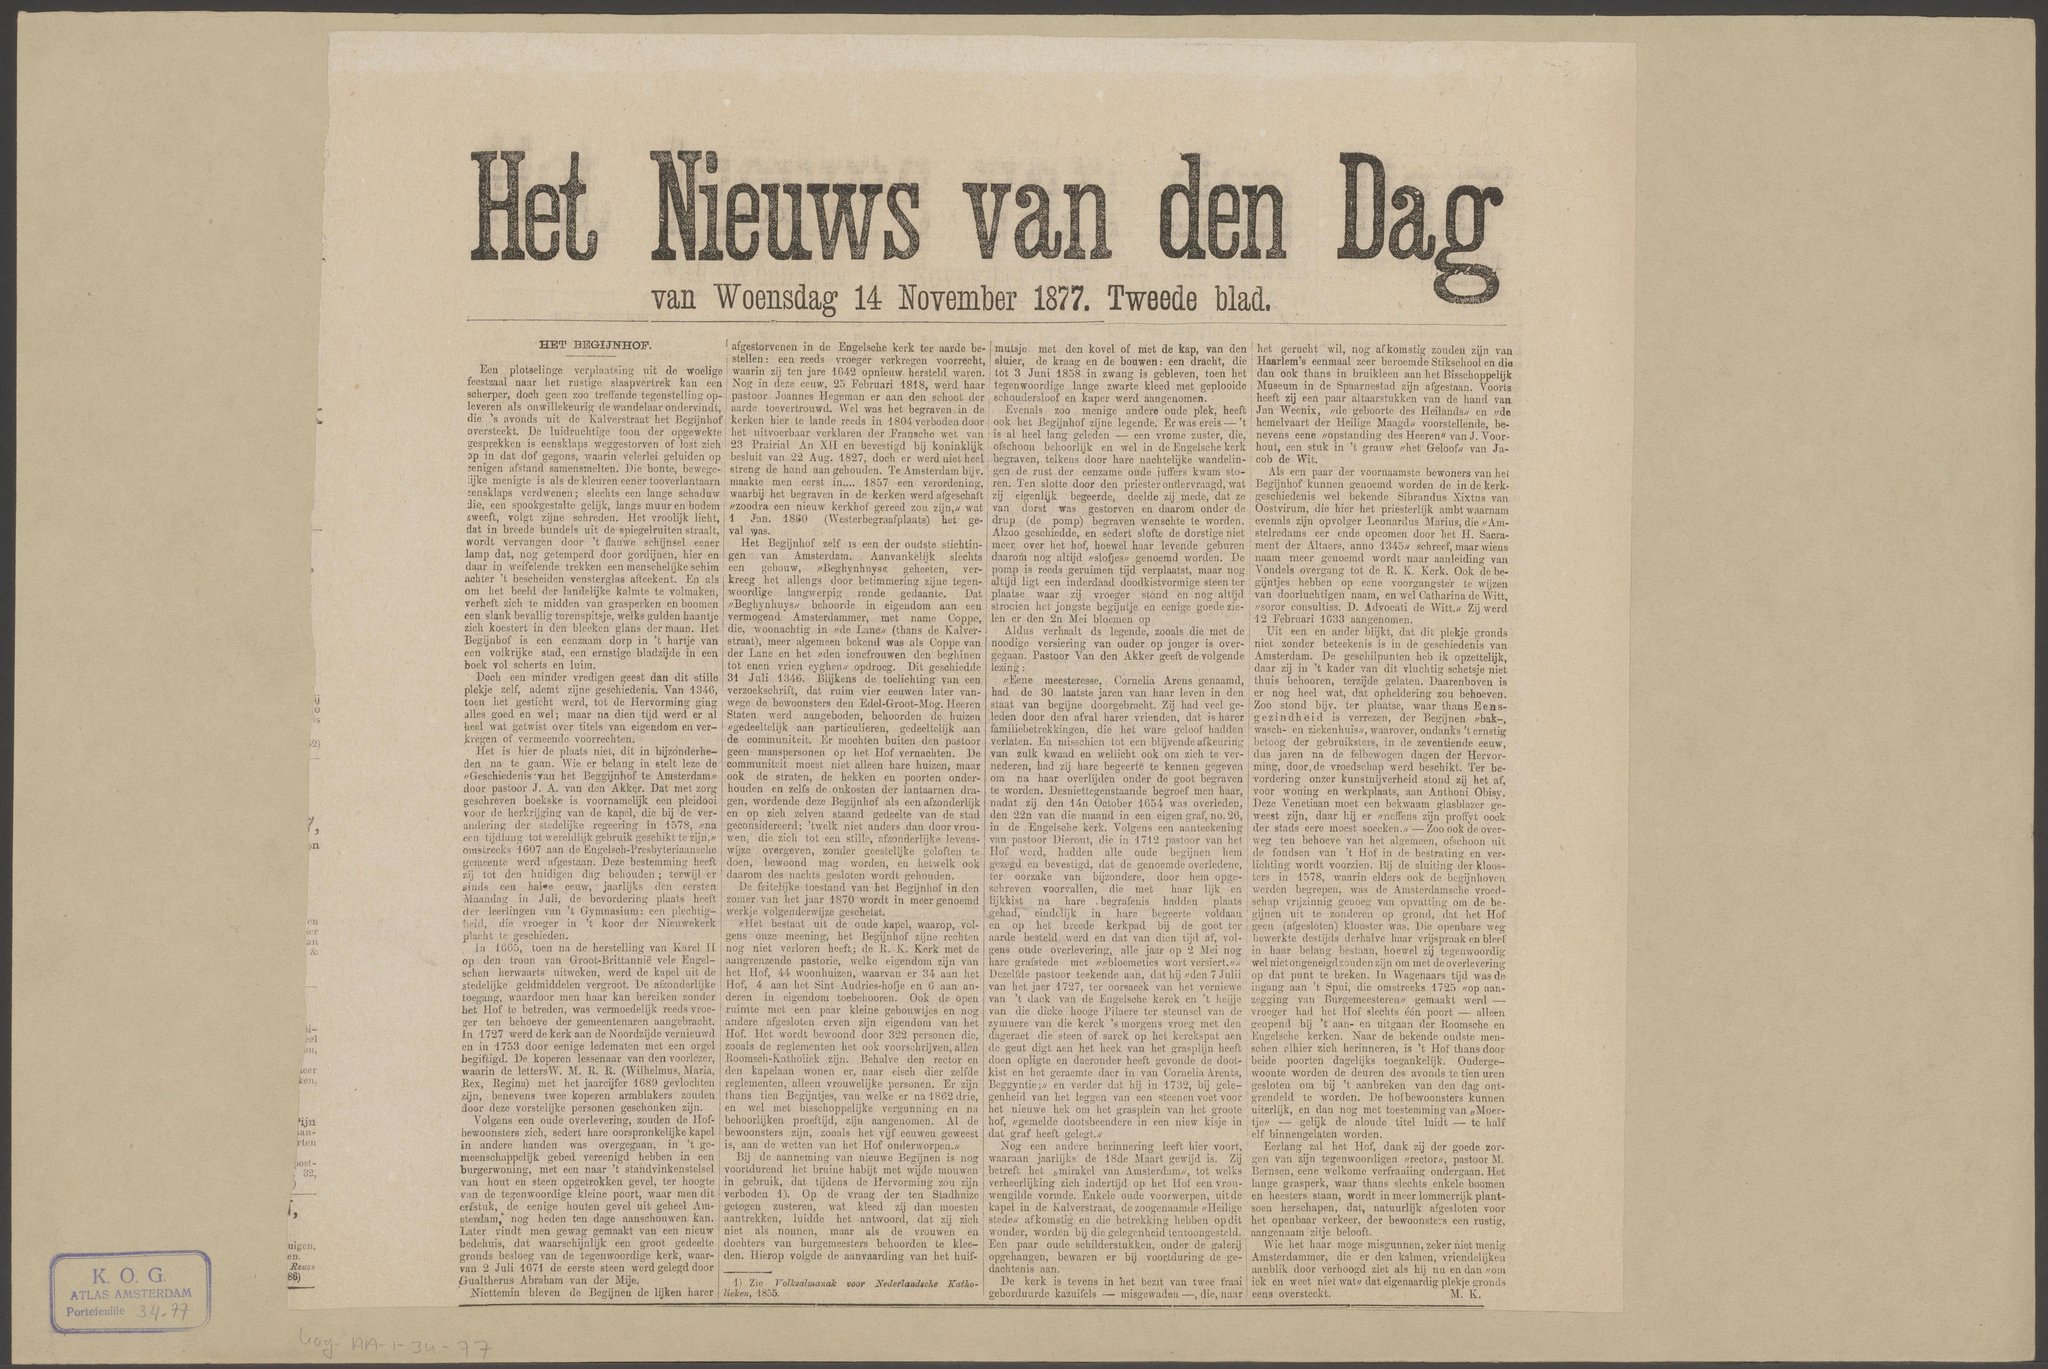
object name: article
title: Het Begijnhof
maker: Anonymous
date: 1877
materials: paper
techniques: letterpress printing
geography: netherlands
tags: abbey, monastery, convent ~ roman catholic church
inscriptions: collector's mark: Lugt 1641b, signature: ‘M.K.’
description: Onderwerpsrubriek binnen de Atlas Amsterdam: Kerkwezen: R.K. Gemeenten: Begijnhof t/m Petrus en Paulus.